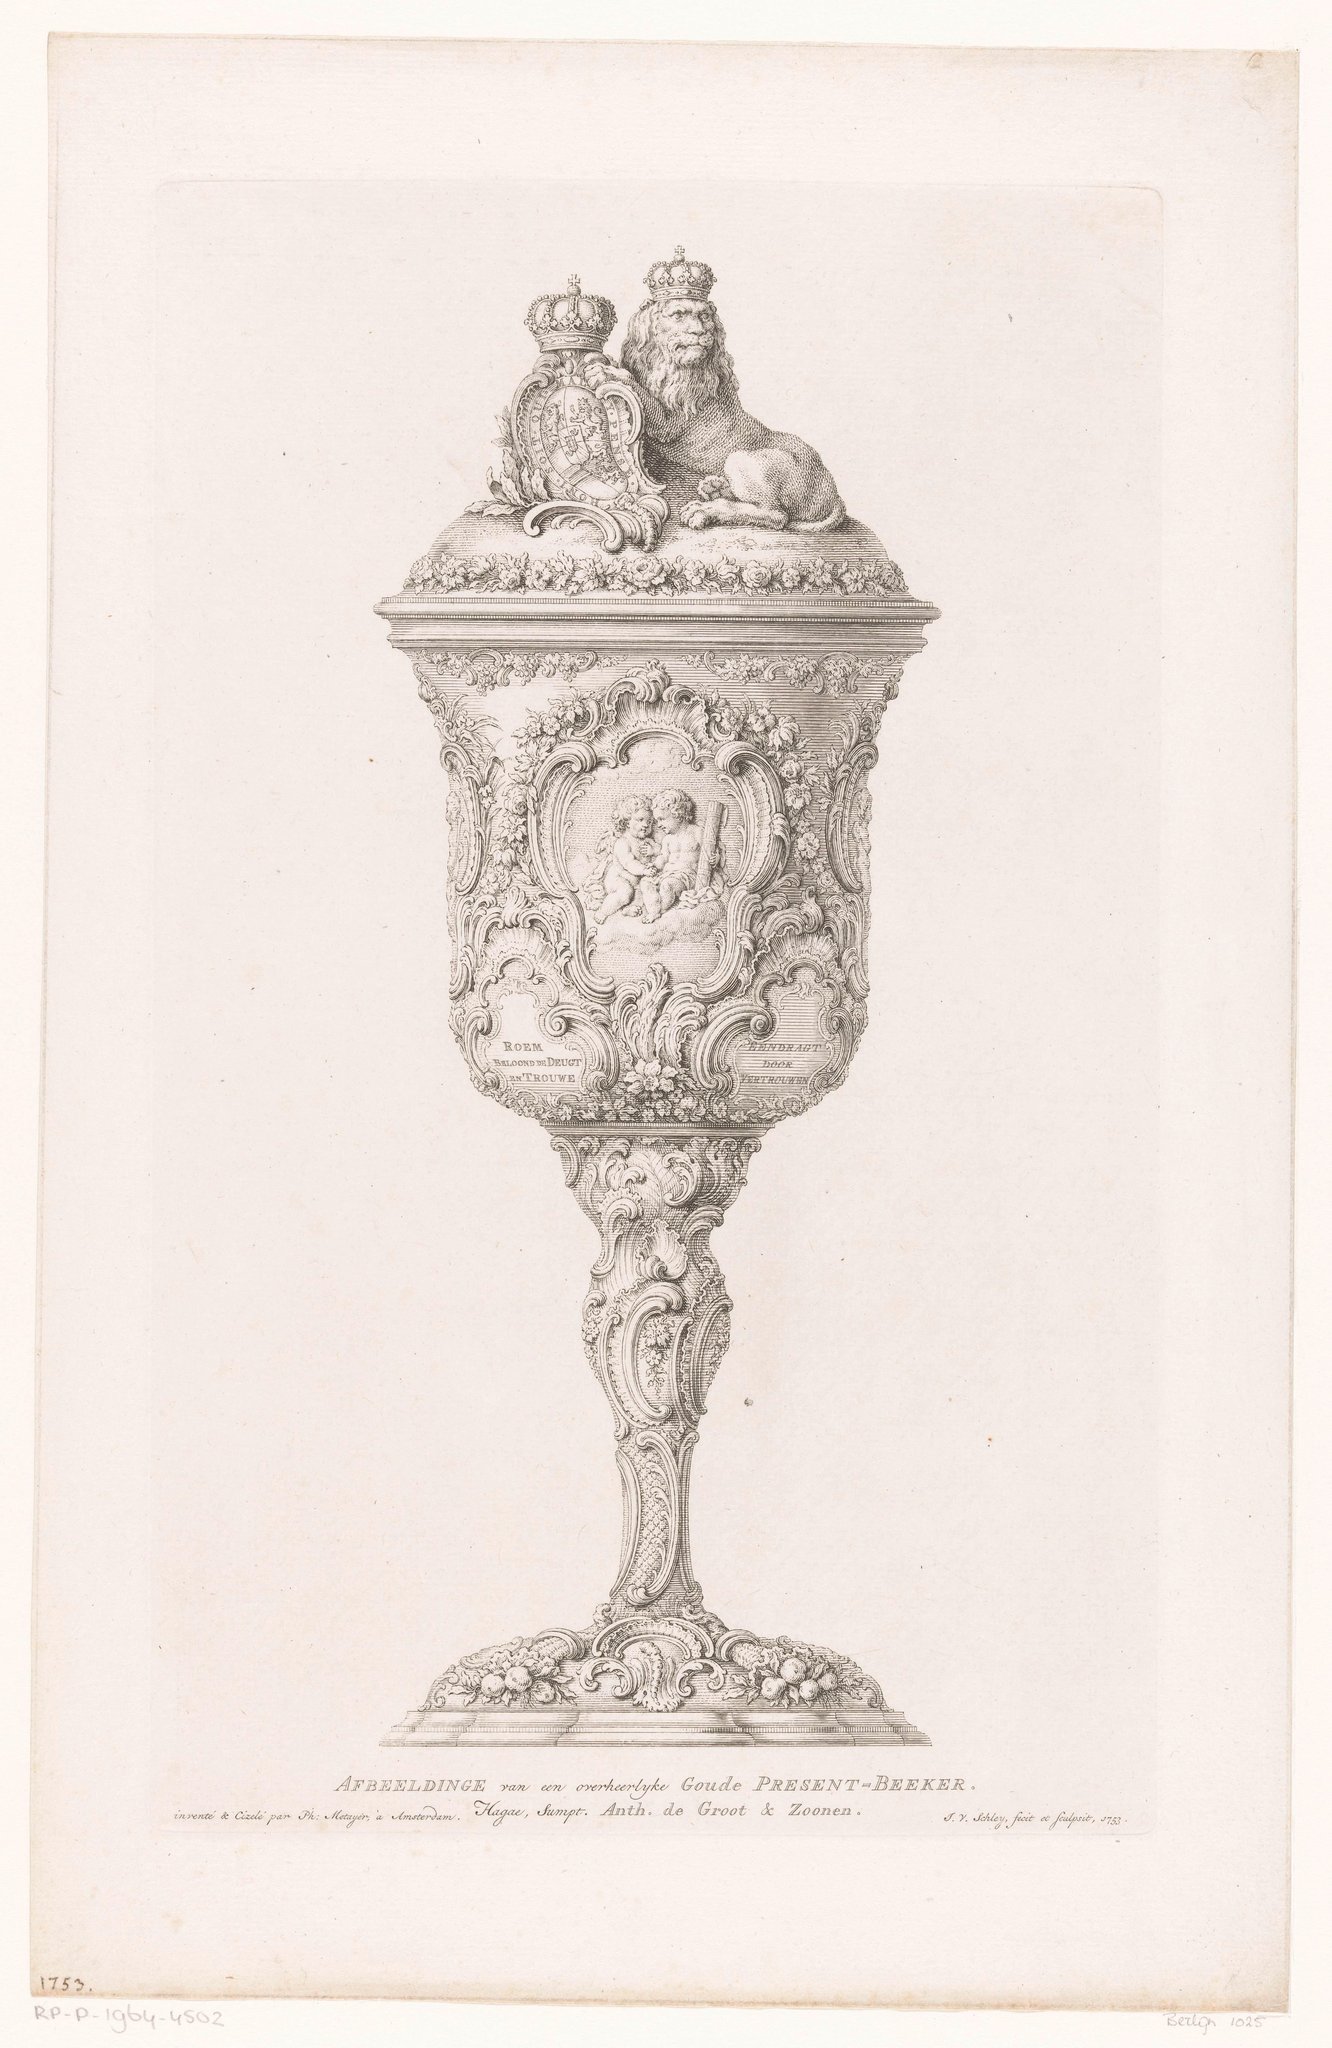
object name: print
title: Afbeeldinge van een overheerlijke Goude Present-Beeker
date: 1753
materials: paper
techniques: engraving, etching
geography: amsterdam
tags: cup, beasts of prey, predatory animals: lion, cupids: 'amores', 'amoretti', 'putti'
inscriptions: collector's mark: Lugt 2760, collector's mark: Lugt 2228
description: Een gouden beker door stadhouder Willem IV toegezegd aan de Haagse schutterij en na zijn dood gepresenteerd door prinses Anna op 8 mei 1753. De beker is gedecoreerd met hoornen des overvloeds, rocailles, guirlandes, rocaille cartouches met putti en rocaille cartouches met teksten. Het deksel is bekroond met een gekroonde leeuw met een gekroond wapenschild met de tekst Honi soit qui mal y pense.